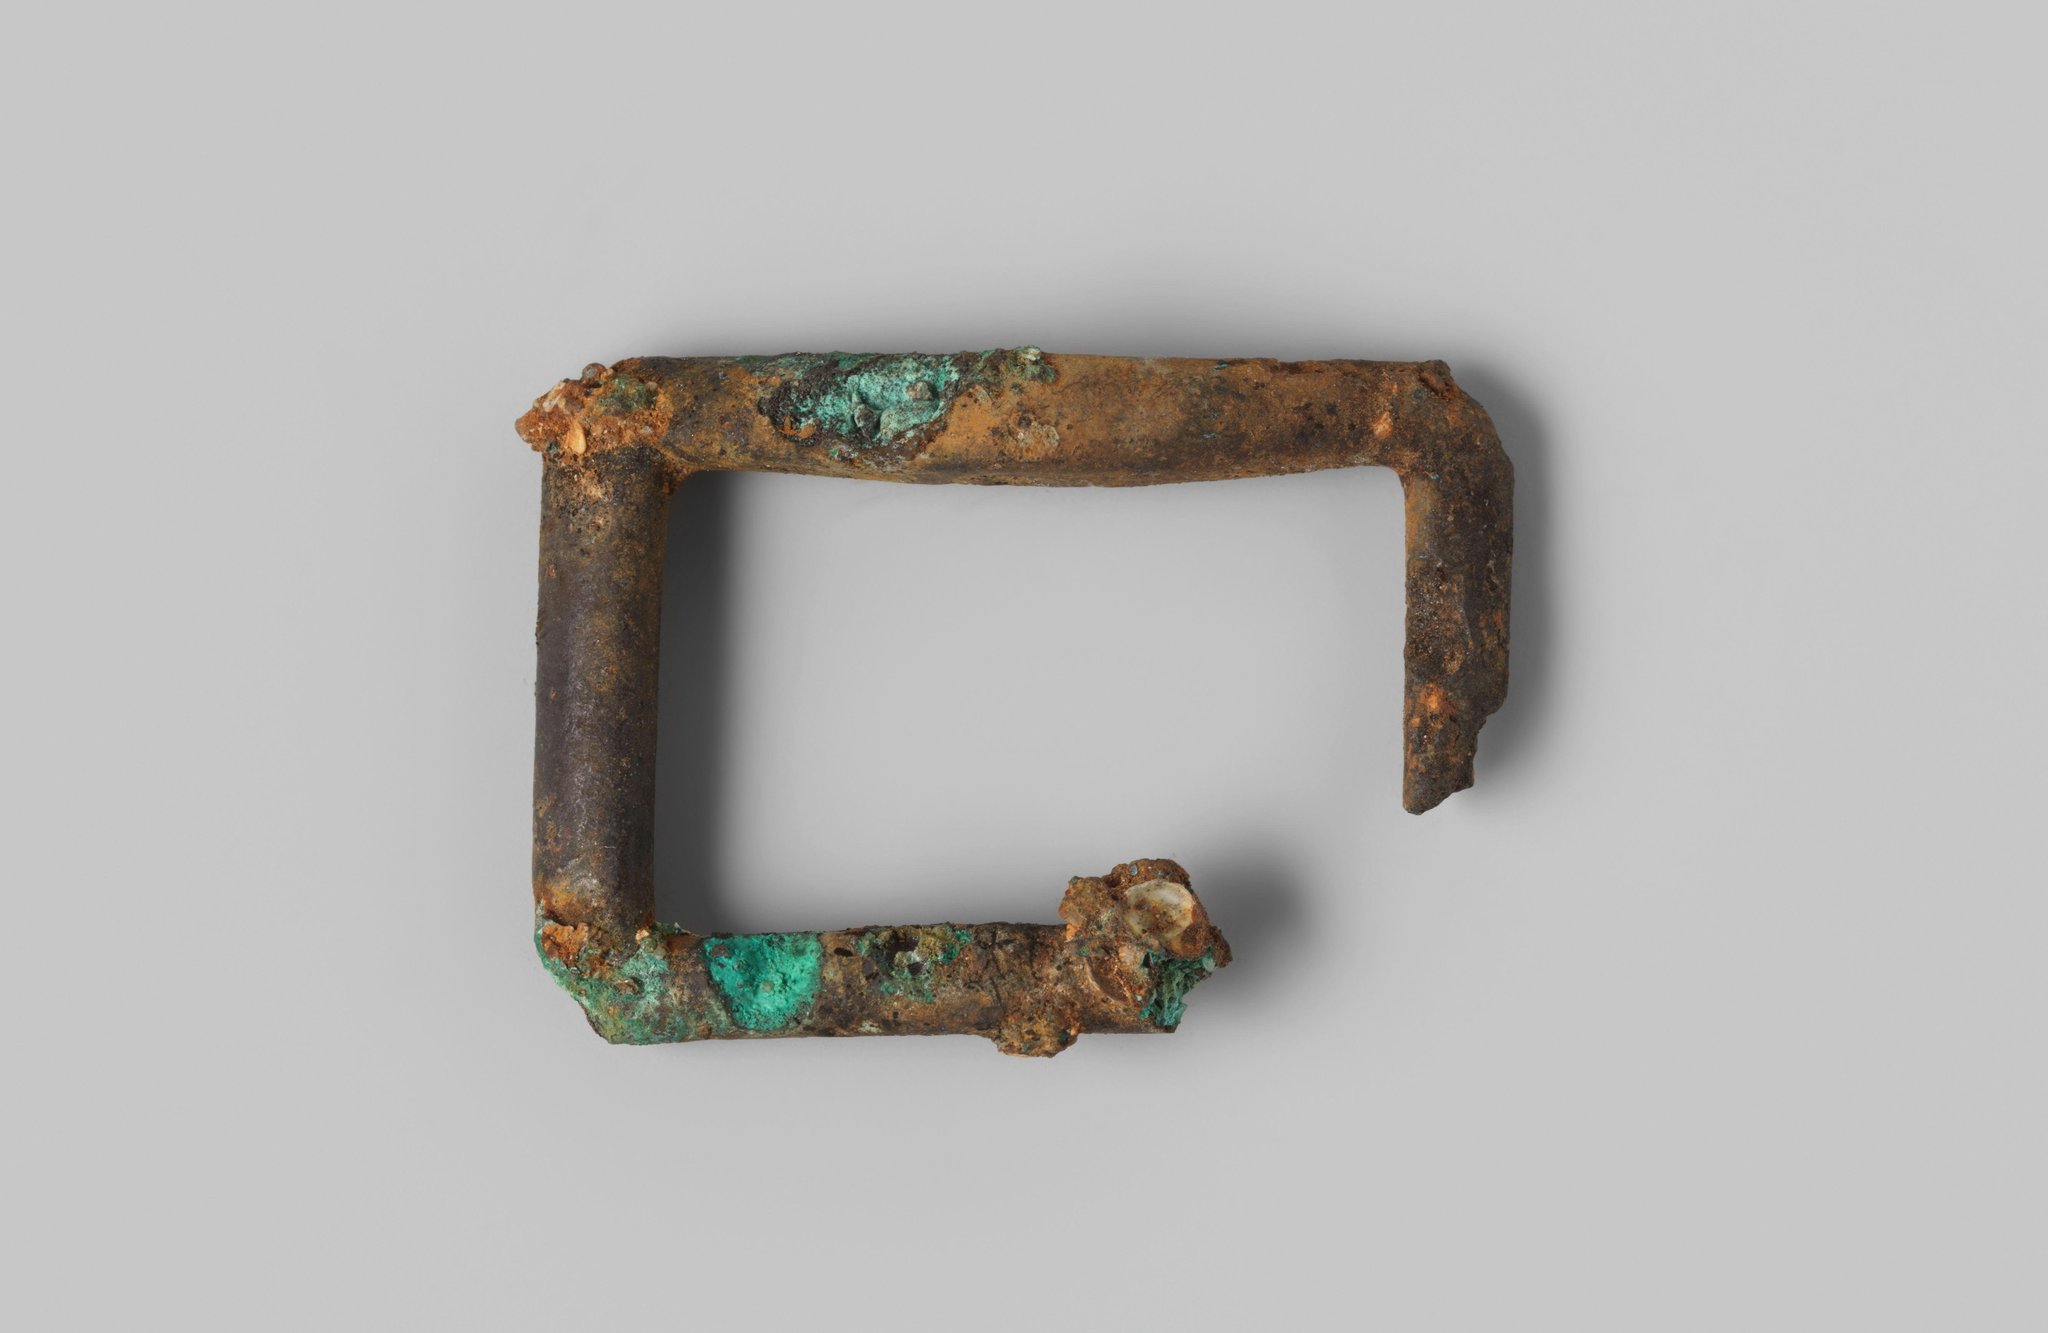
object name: shoe buckle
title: Fragment schoengesp uit het wrak van de Oost-Indiëvaarder Hollandia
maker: Anonymous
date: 1700-1743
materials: copper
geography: netherlands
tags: verenigde oostindische compagnie, hollandia (schip), annet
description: Buckle, chape buckle, shoe buckle; fragment of ring, broken, octagonal outline, plain.